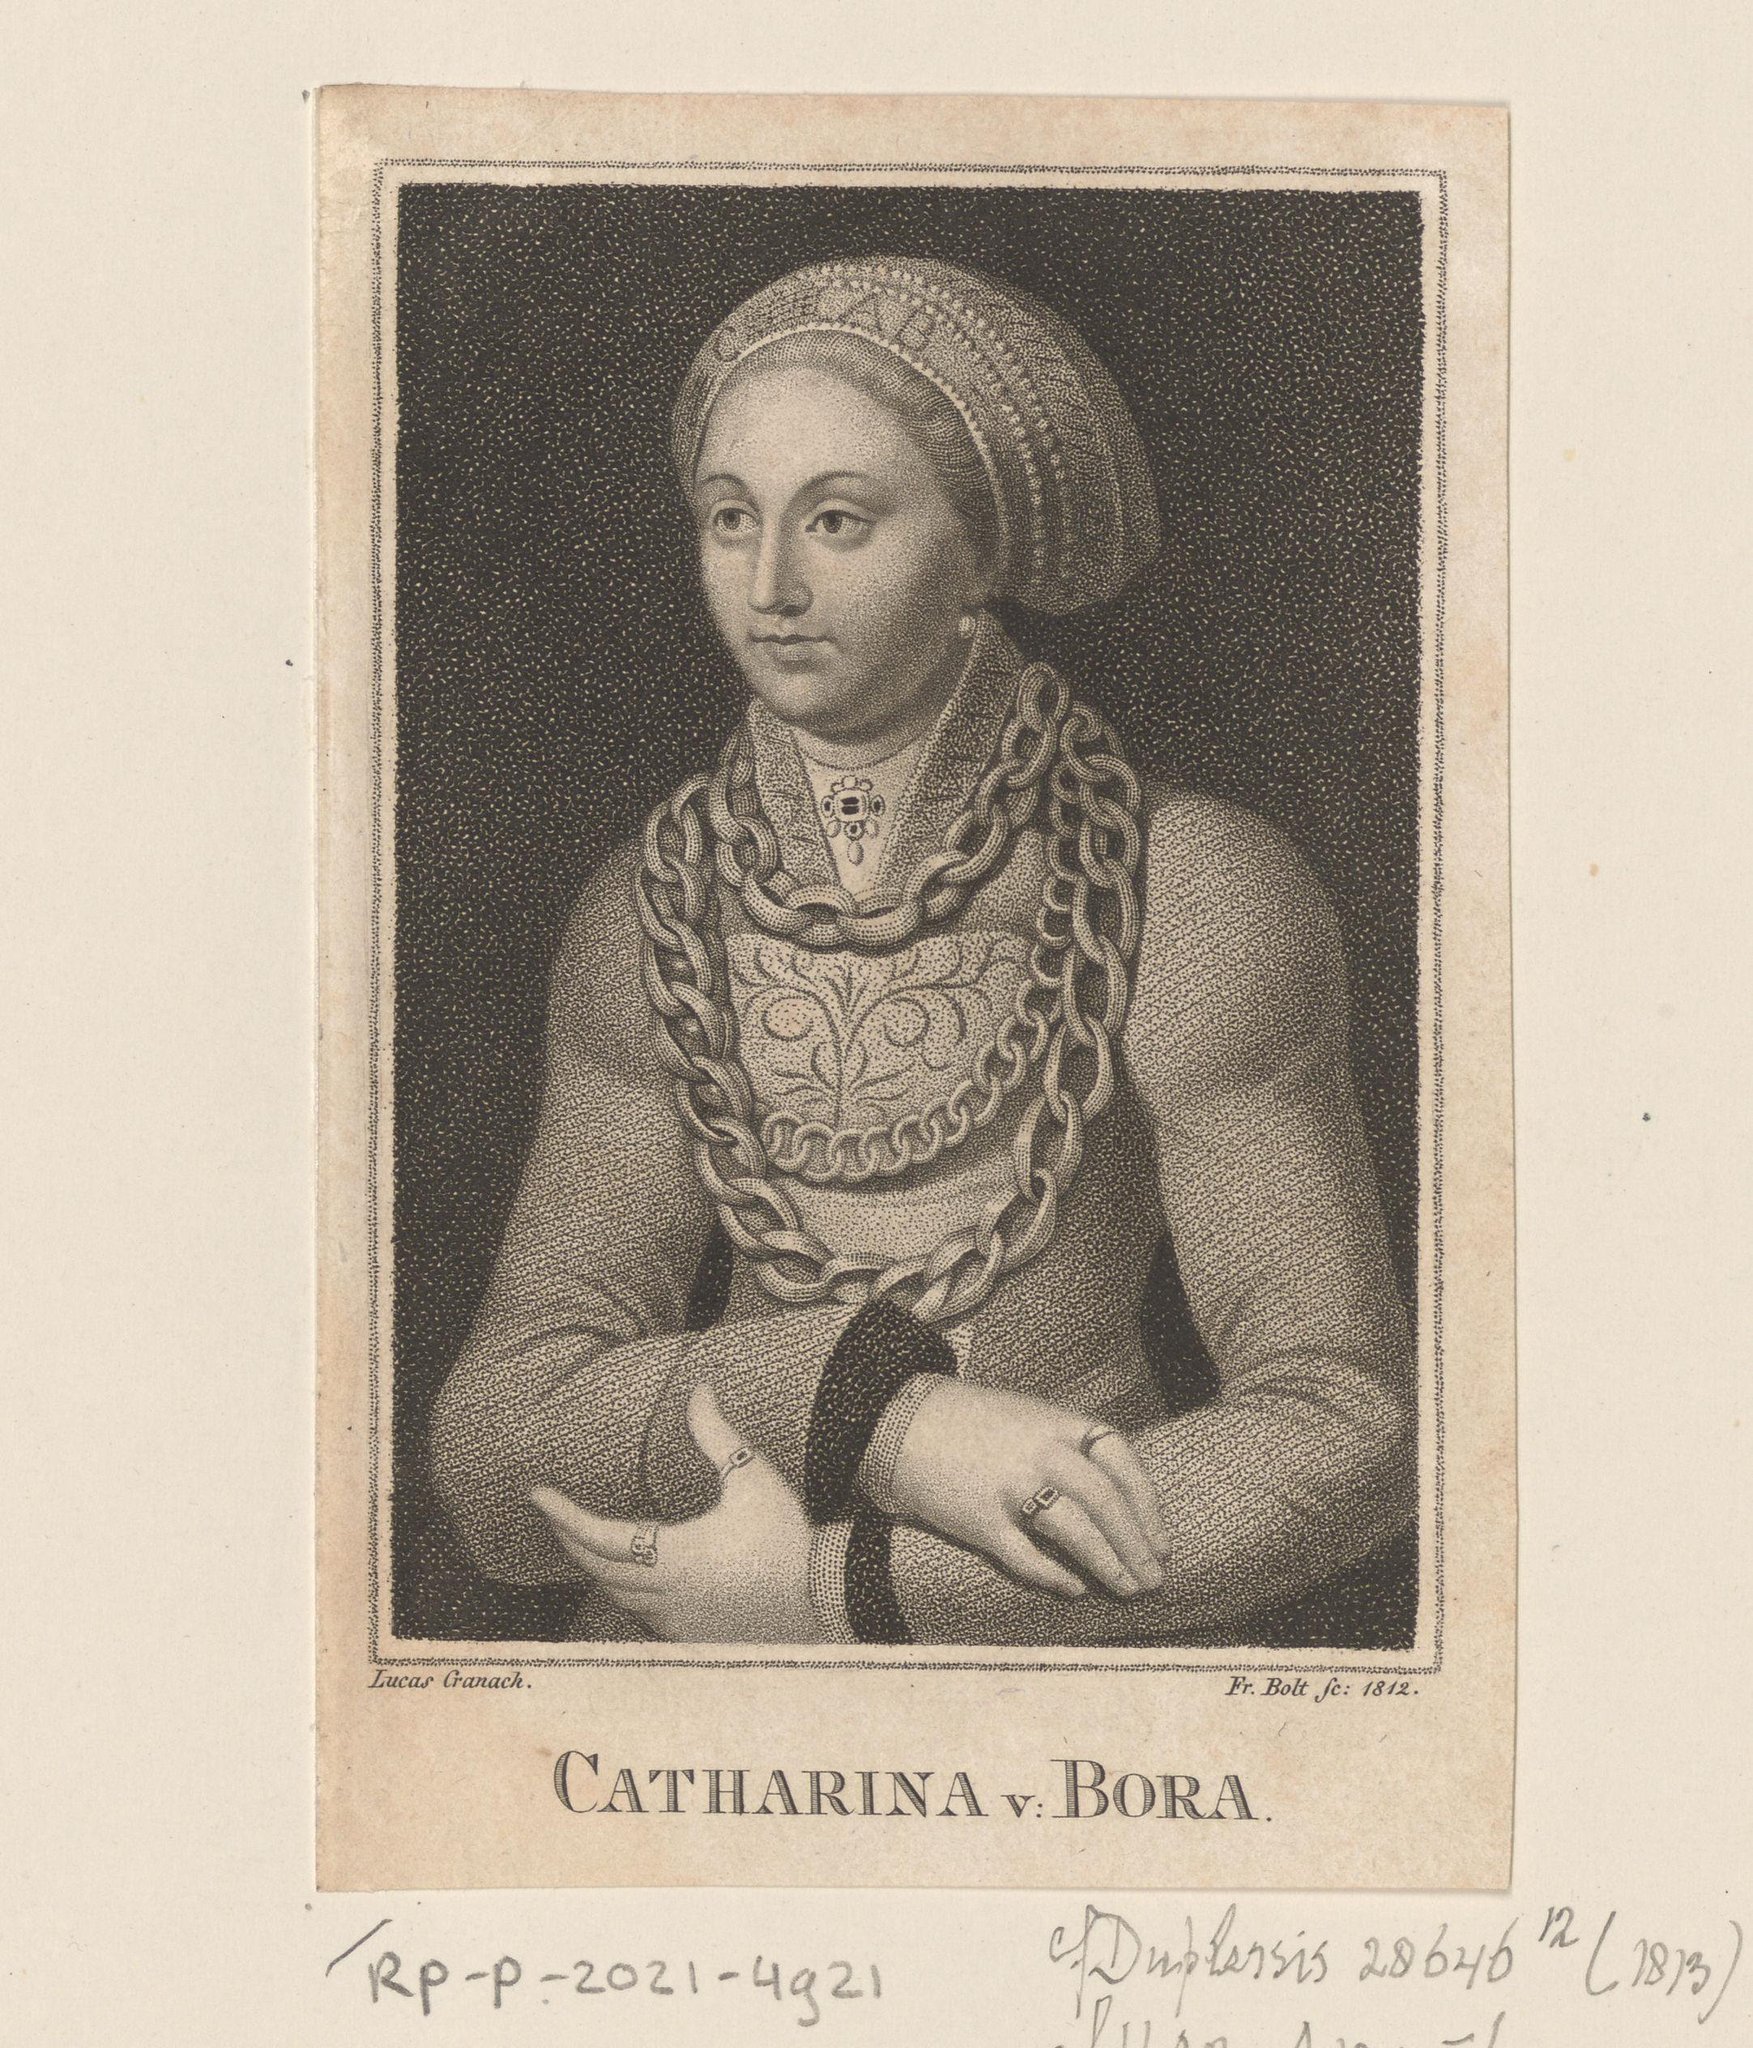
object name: print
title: Portret van Katharina von Bora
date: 1812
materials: paper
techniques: engraving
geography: germany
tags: historical persons - bb - woman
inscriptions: date